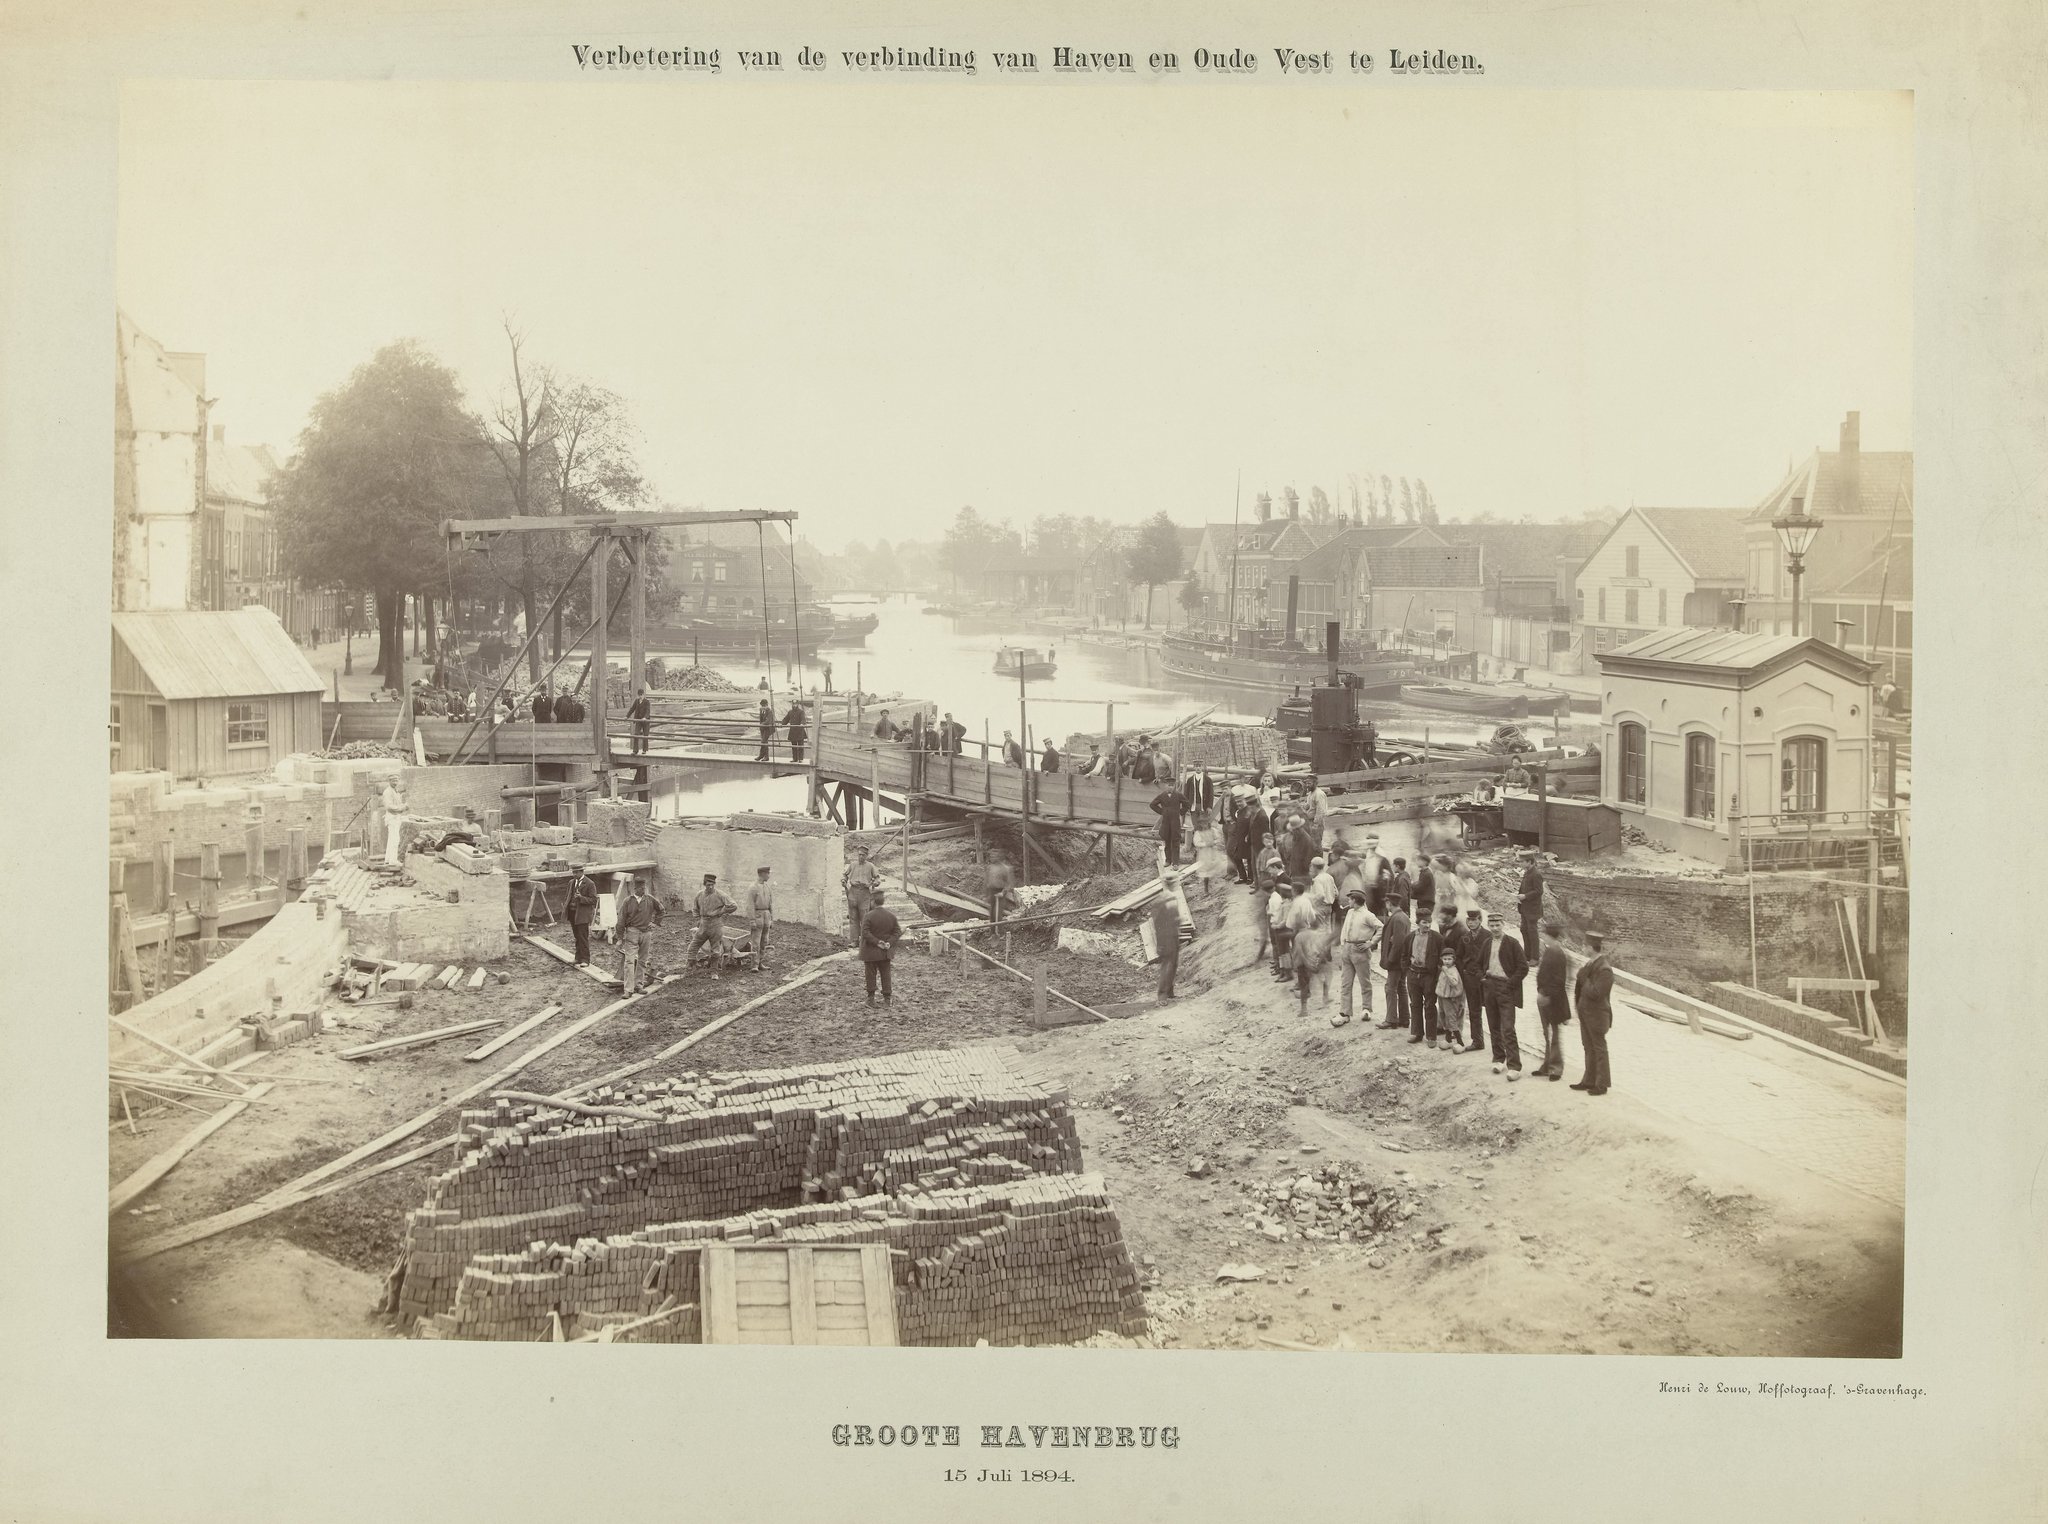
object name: photograph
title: Werkzaamheden aan de Grote Havenbrug te Leiden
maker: henri de louw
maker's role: fotograaf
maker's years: 1851-1944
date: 1894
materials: cardboard, photographic support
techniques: albumen print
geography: the hague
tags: bridge in city across river, canal, etc., leiden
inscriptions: date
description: Werkzaamheden aan de Grote Havenbrug te Leiden in de tijdelijke situatie met een houten constructie voordat de dubbele ophaalbrug geplaatst werd in 1894-1895.